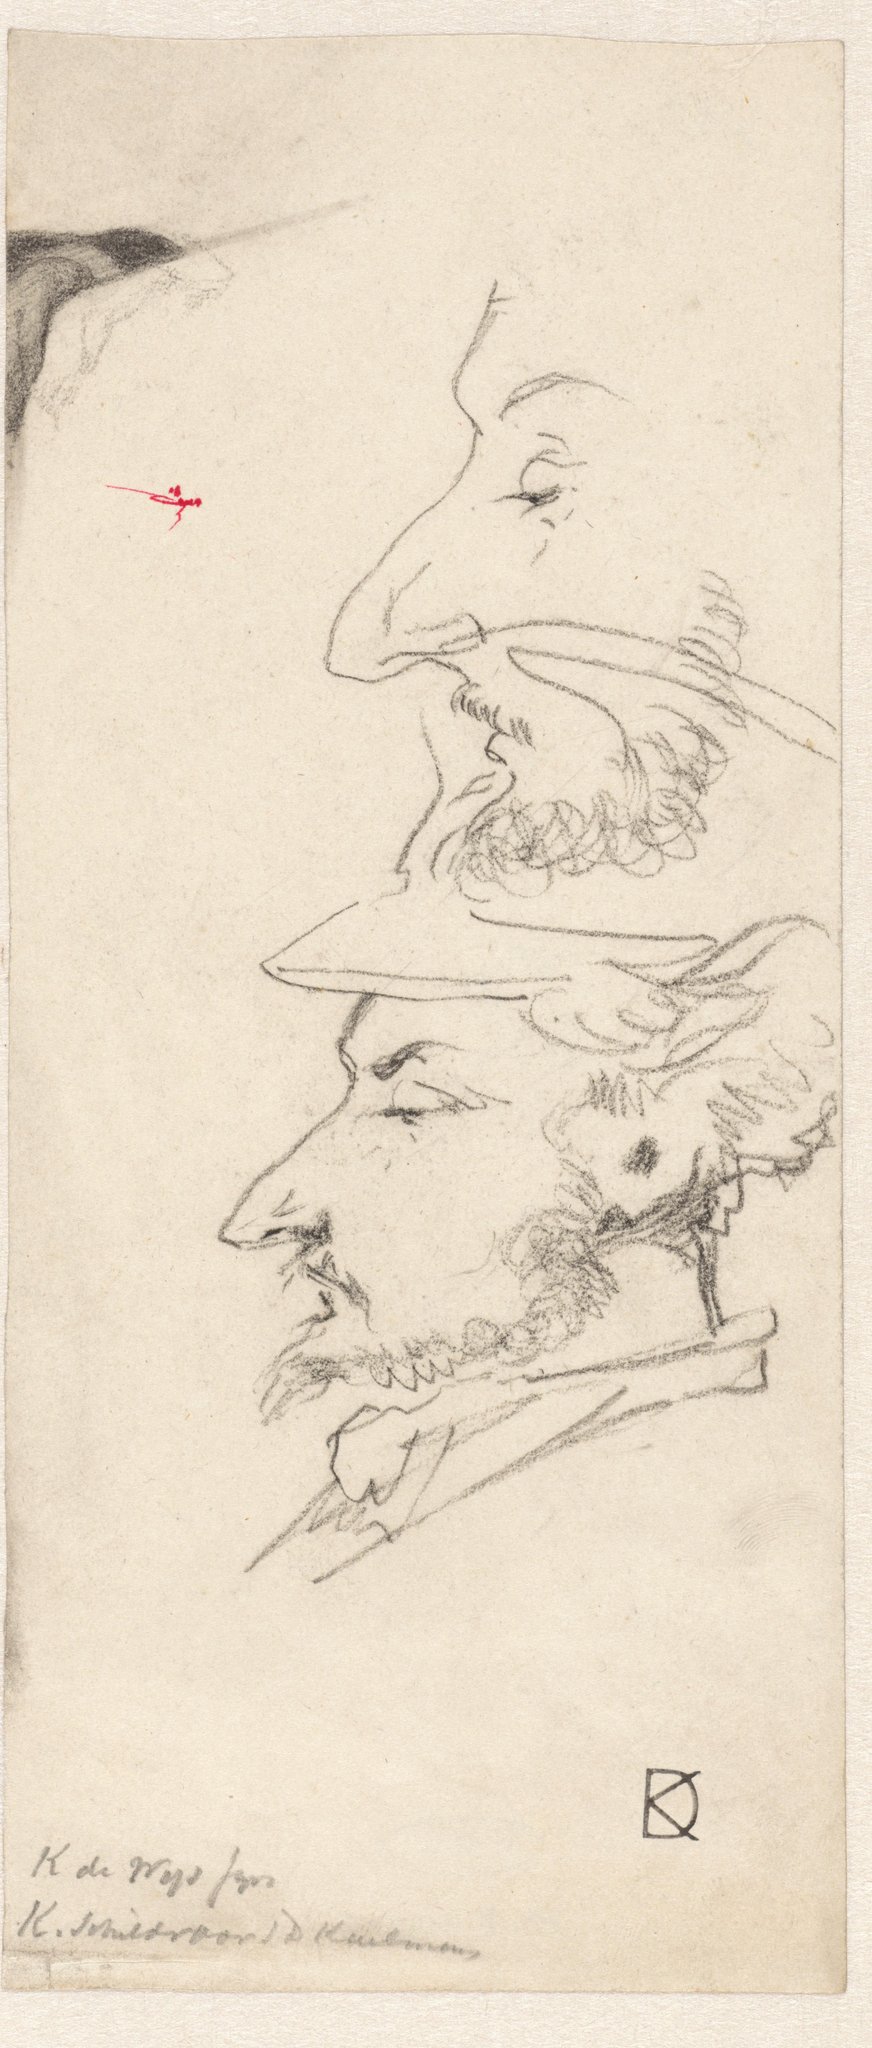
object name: drawing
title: Portret van de kunstschilder K. de Wijs Jzn, en profil naar links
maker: johan daniël koelman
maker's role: draughtsman, print maker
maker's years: 1831-1857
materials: chalk, paper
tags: dordrecht, print maker, kornelis jzn de wijs, portrait, self-portrait of painter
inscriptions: workshop stamp: Lugt 767, annotation: ‘K. de Wijs Jzn. / K. Schilderaar’, signature: ‘J.D. Koelman.’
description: Portret van de kunstschilder K. de Wijs Jzn, en profil naar links. Het hoofd is twee keer geschetst.